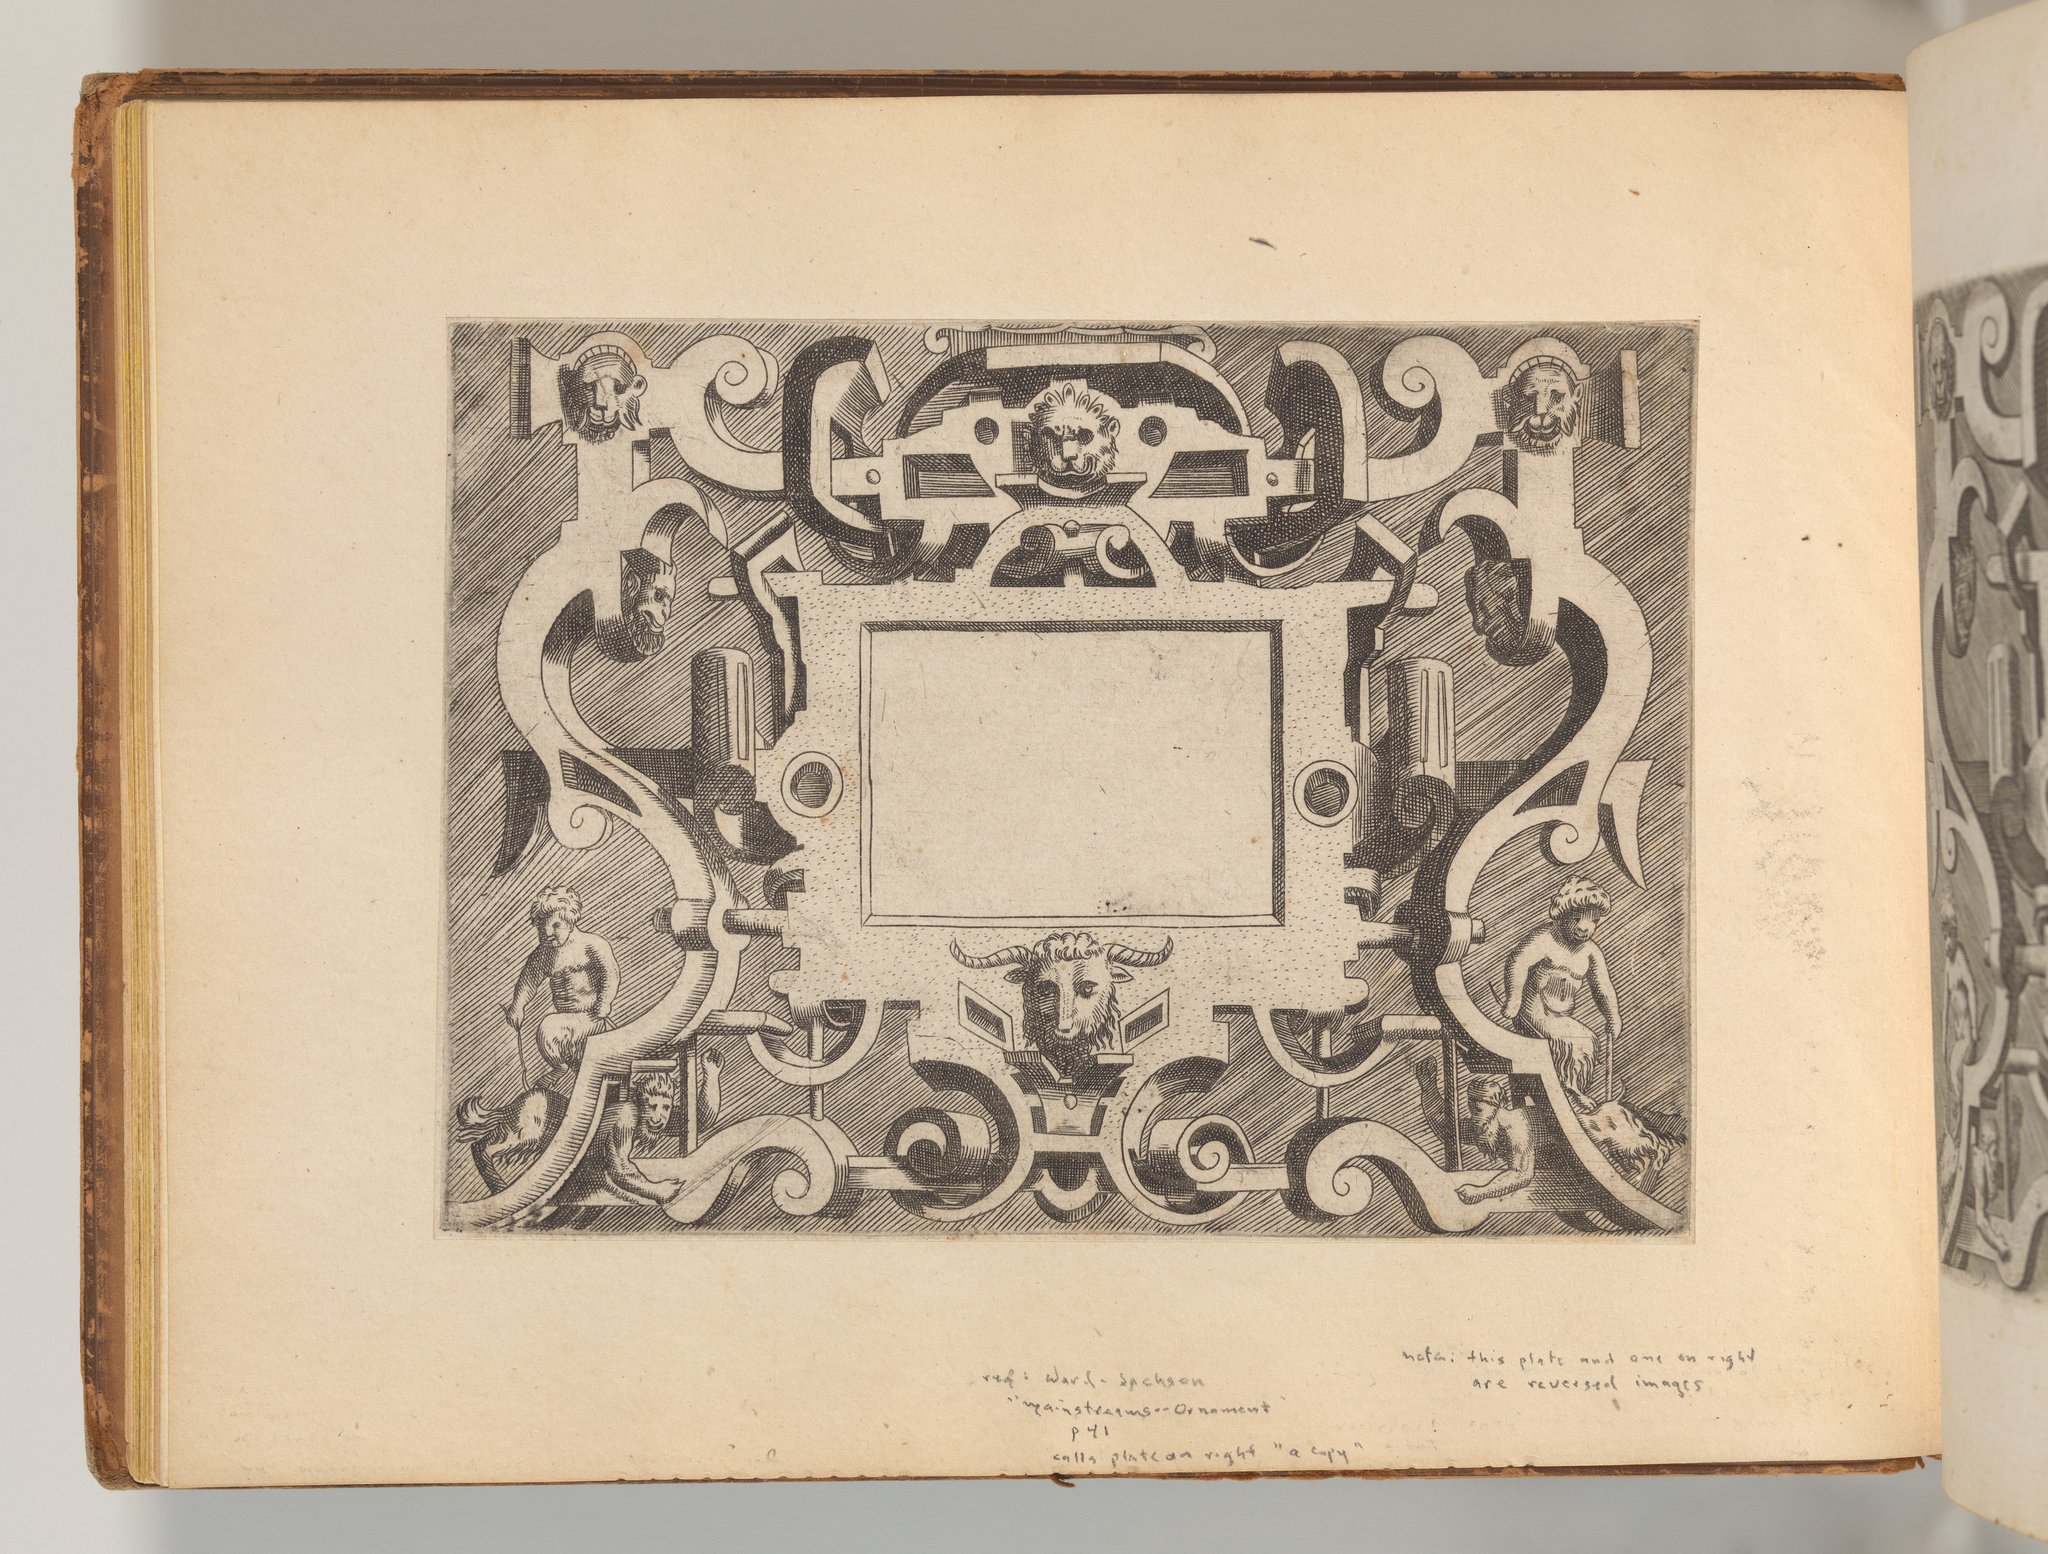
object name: album print ornament architecture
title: Targhe ed altri ornati di varie e capricciose invenzioni (Cartouches and other ornaments of various and capricious invention, page 19)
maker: hans vredeman de vries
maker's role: artist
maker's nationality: netherlandish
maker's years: 1527-1606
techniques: engraving, etching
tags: cartouches,lions,rams